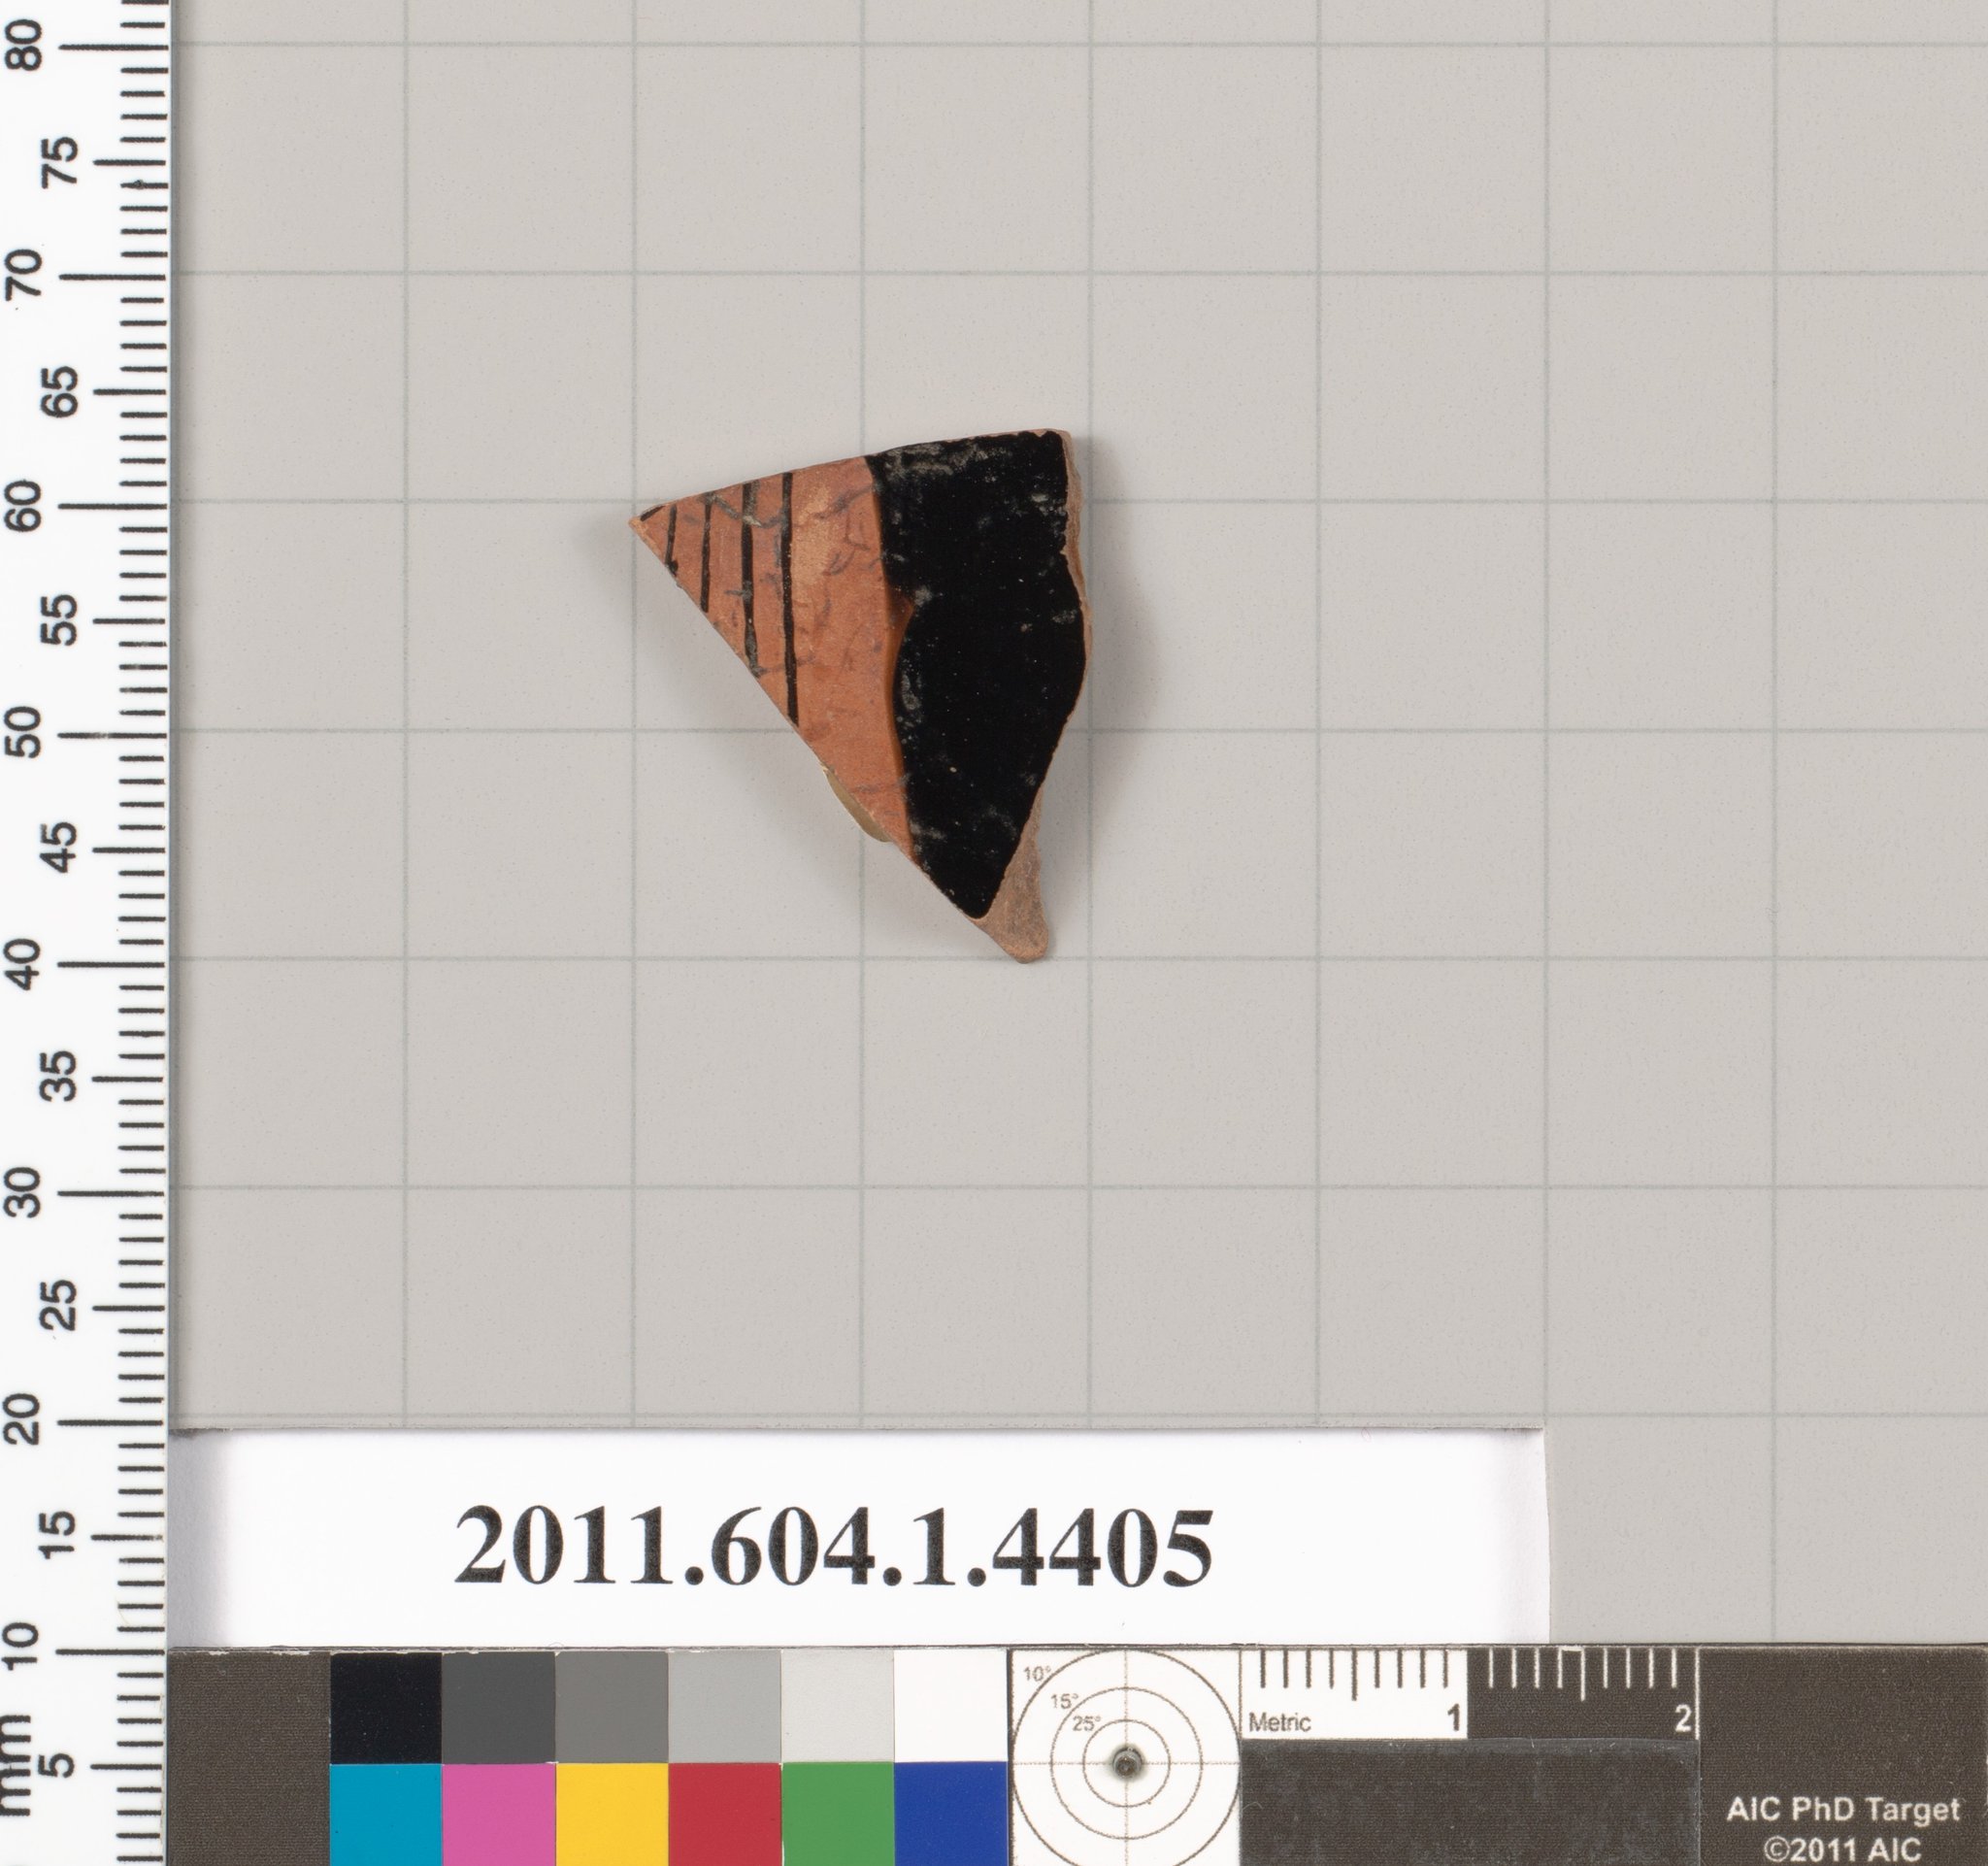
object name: kylix fragment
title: Terracotta fragment of a kylix (drinking cup)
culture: greek, attic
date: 490-470 BCE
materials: terracotta